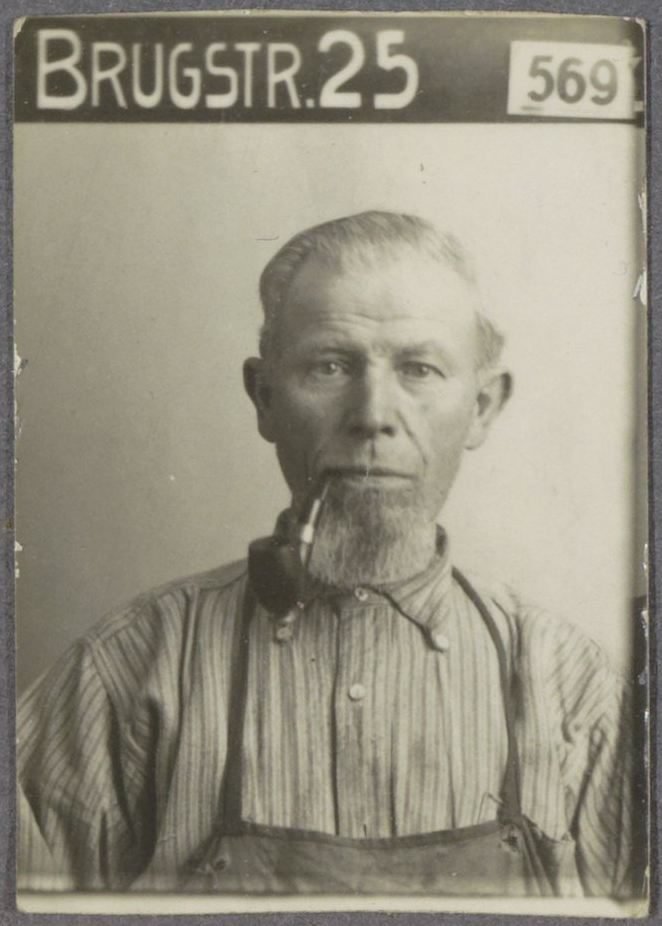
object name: album leaf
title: Portret van een man met een baard en een pijp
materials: paper, cardboard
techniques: gelatin silver print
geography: groningen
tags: adult man, historical persons, pipe ~ tobacco, beard, netherlands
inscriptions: number: ‘569’, address: ‘Brugstraat 25’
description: Onderdeel van Fotoalbum met portretten vervaardigd door Nederlandse studio's waaronder automaatfoto's.